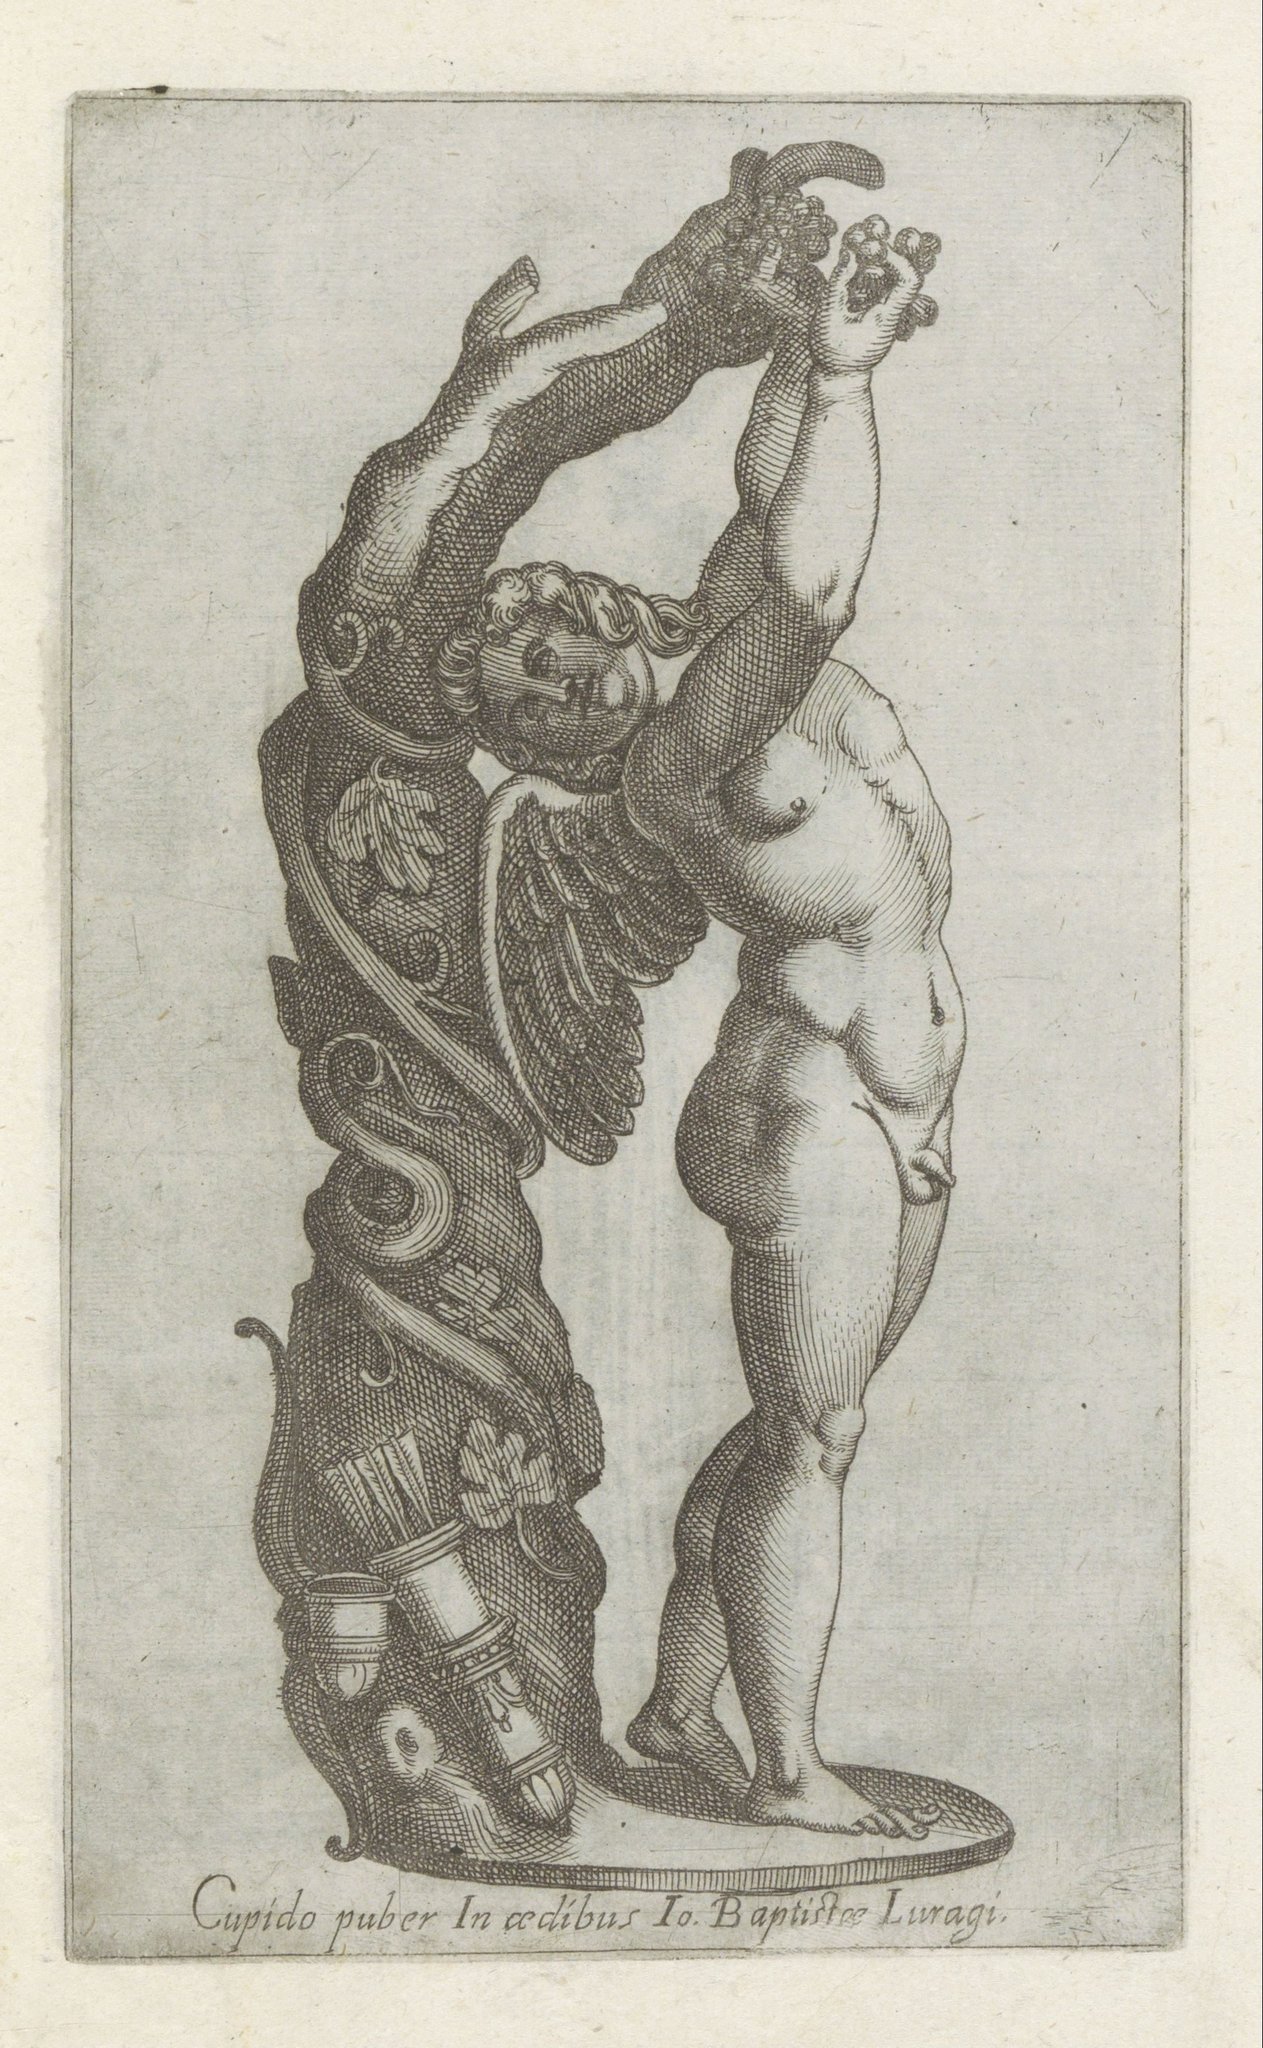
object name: print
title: Antiquarum statuarum urbis Romae quae in publicis locis visuntur icones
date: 1584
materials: paper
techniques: engraving, intaglio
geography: rome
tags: piece of sculpture, reproduction of a piece of sculpture, (story of) cupid, amor (eros)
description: Deze prent maakt deel uit van een set van 79 prenten (+ titelprent) met voorstellingen van antieke sculpturen in Rome.